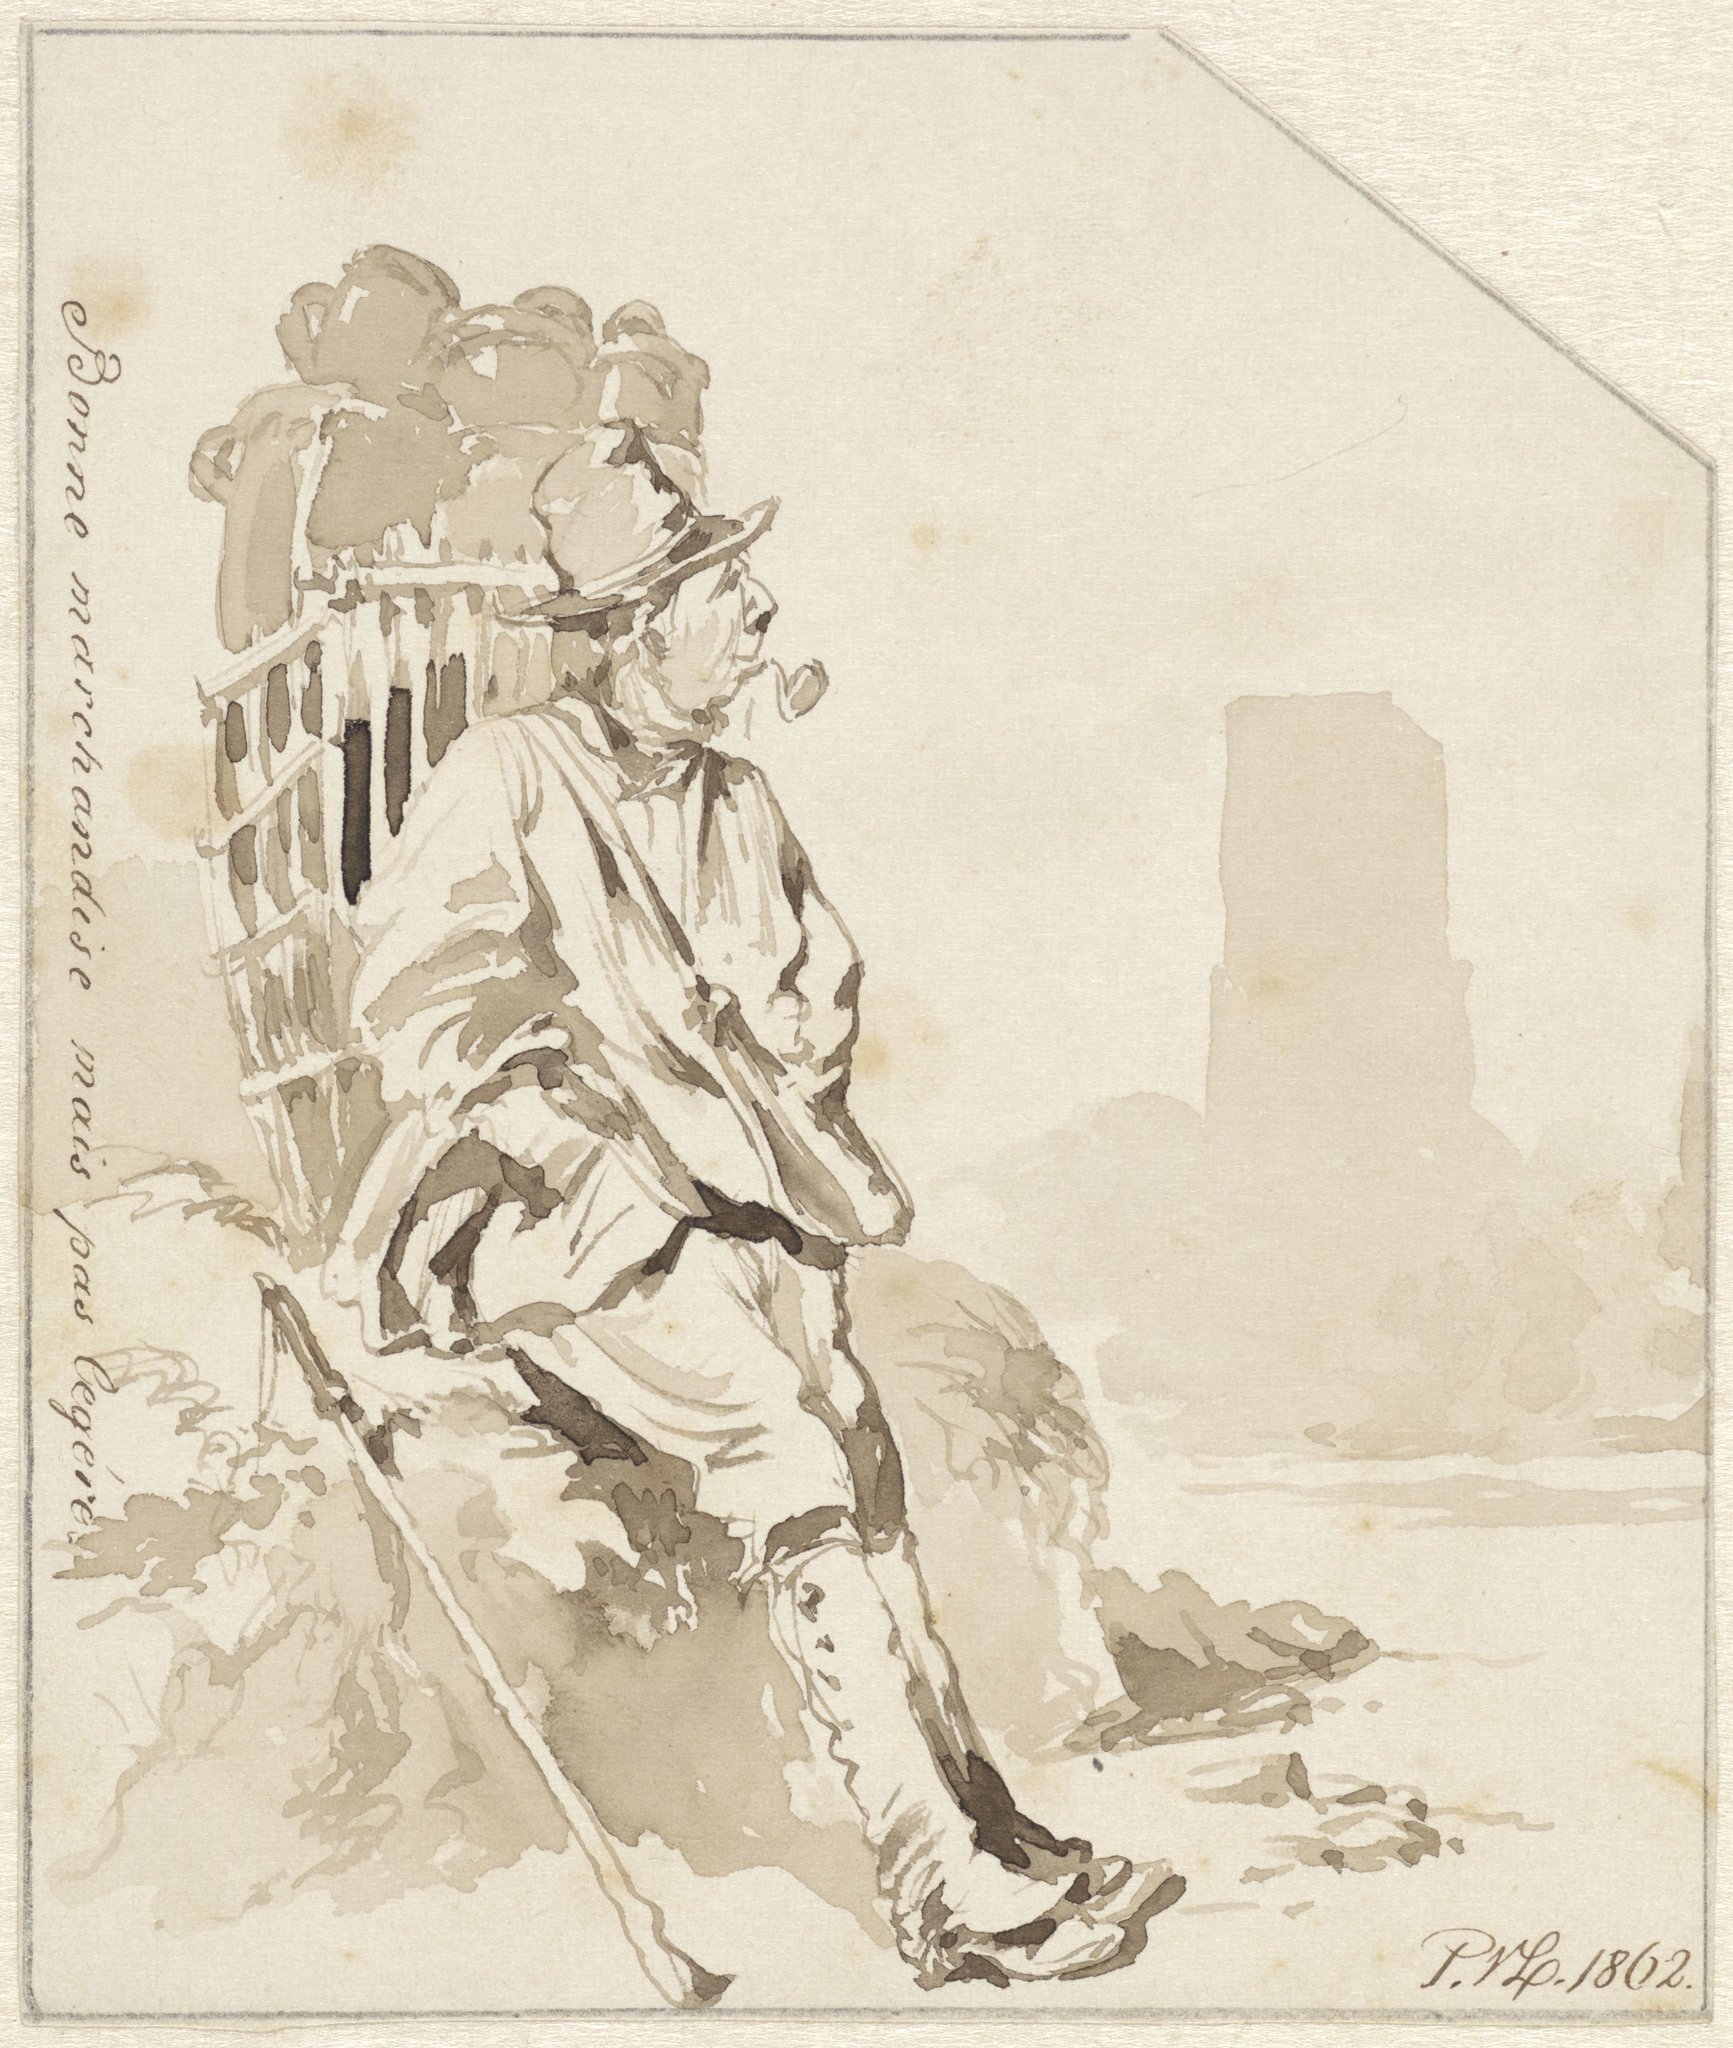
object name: drawing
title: Rustende marskramer met aardewerk in zijn korf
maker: pieter van loon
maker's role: draughtsman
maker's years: 1801-1873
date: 1862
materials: paper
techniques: brush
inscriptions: inscription: ‘Bonne marchandise mais pas legére’, monogram and date: ‘P.vL.1862’